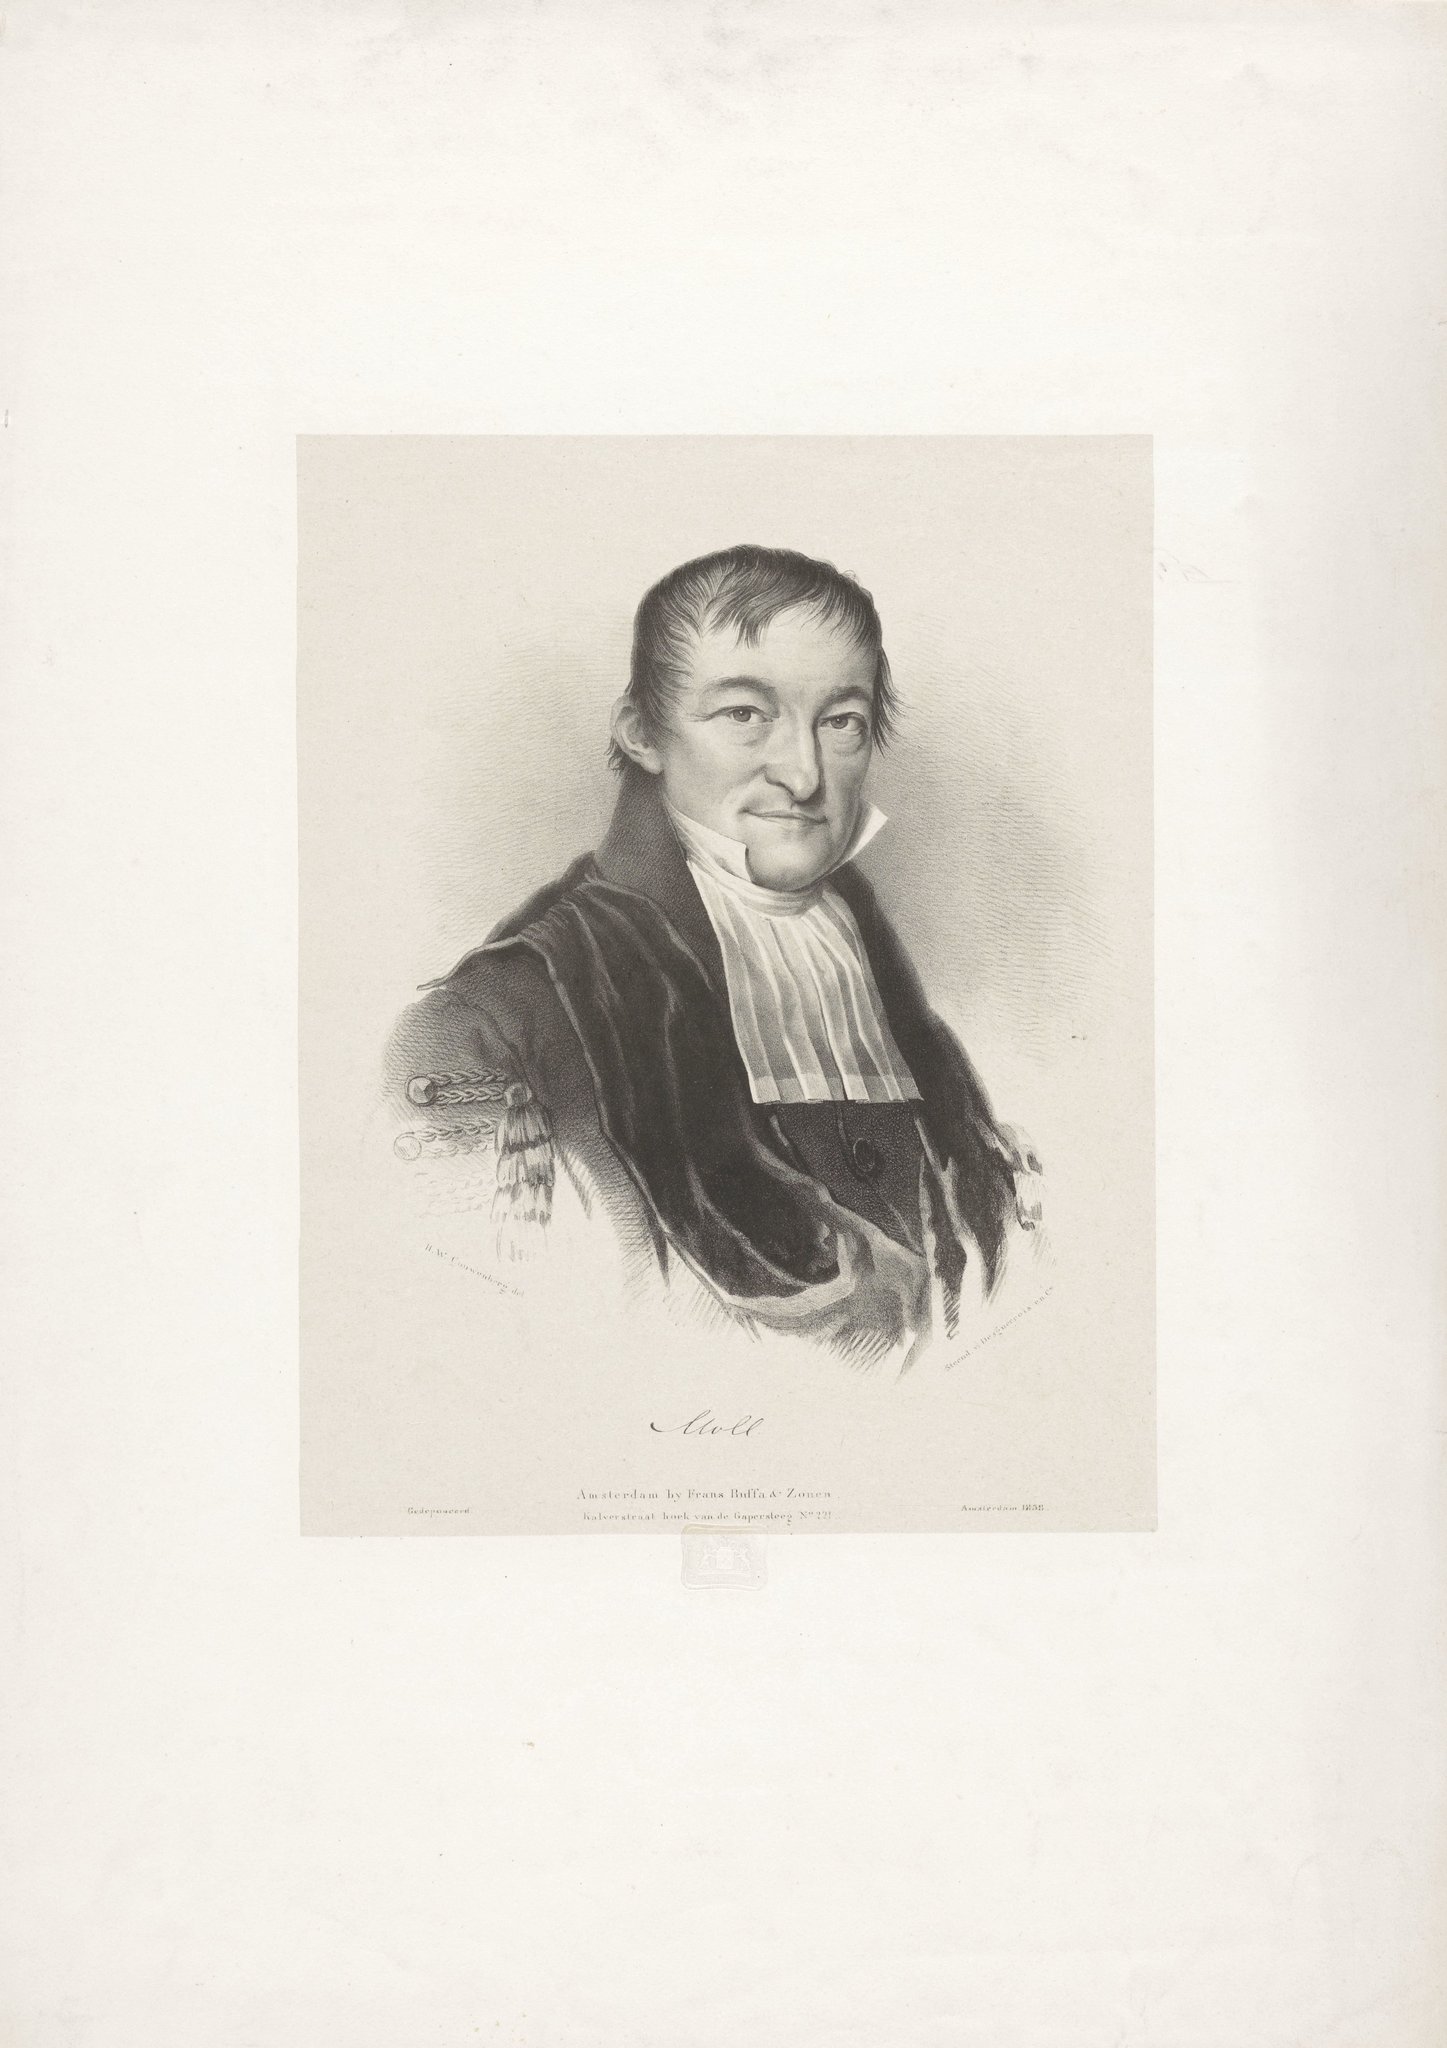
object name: print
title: Portret van Gerrit Moll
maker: henricus wilhelmus couwenberg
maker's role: draughtsman, print maker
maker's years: 1814-1845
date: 1838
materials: paper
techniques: lithograph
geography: amsterdam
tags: professor, historical persons (+ (full) bust portrait)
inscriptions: collector's mark: Lugt 2228, : ‘Gedeponeerd.’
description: De geportretteerde draagt een toga en een witte bef met opstaande witte kraag.